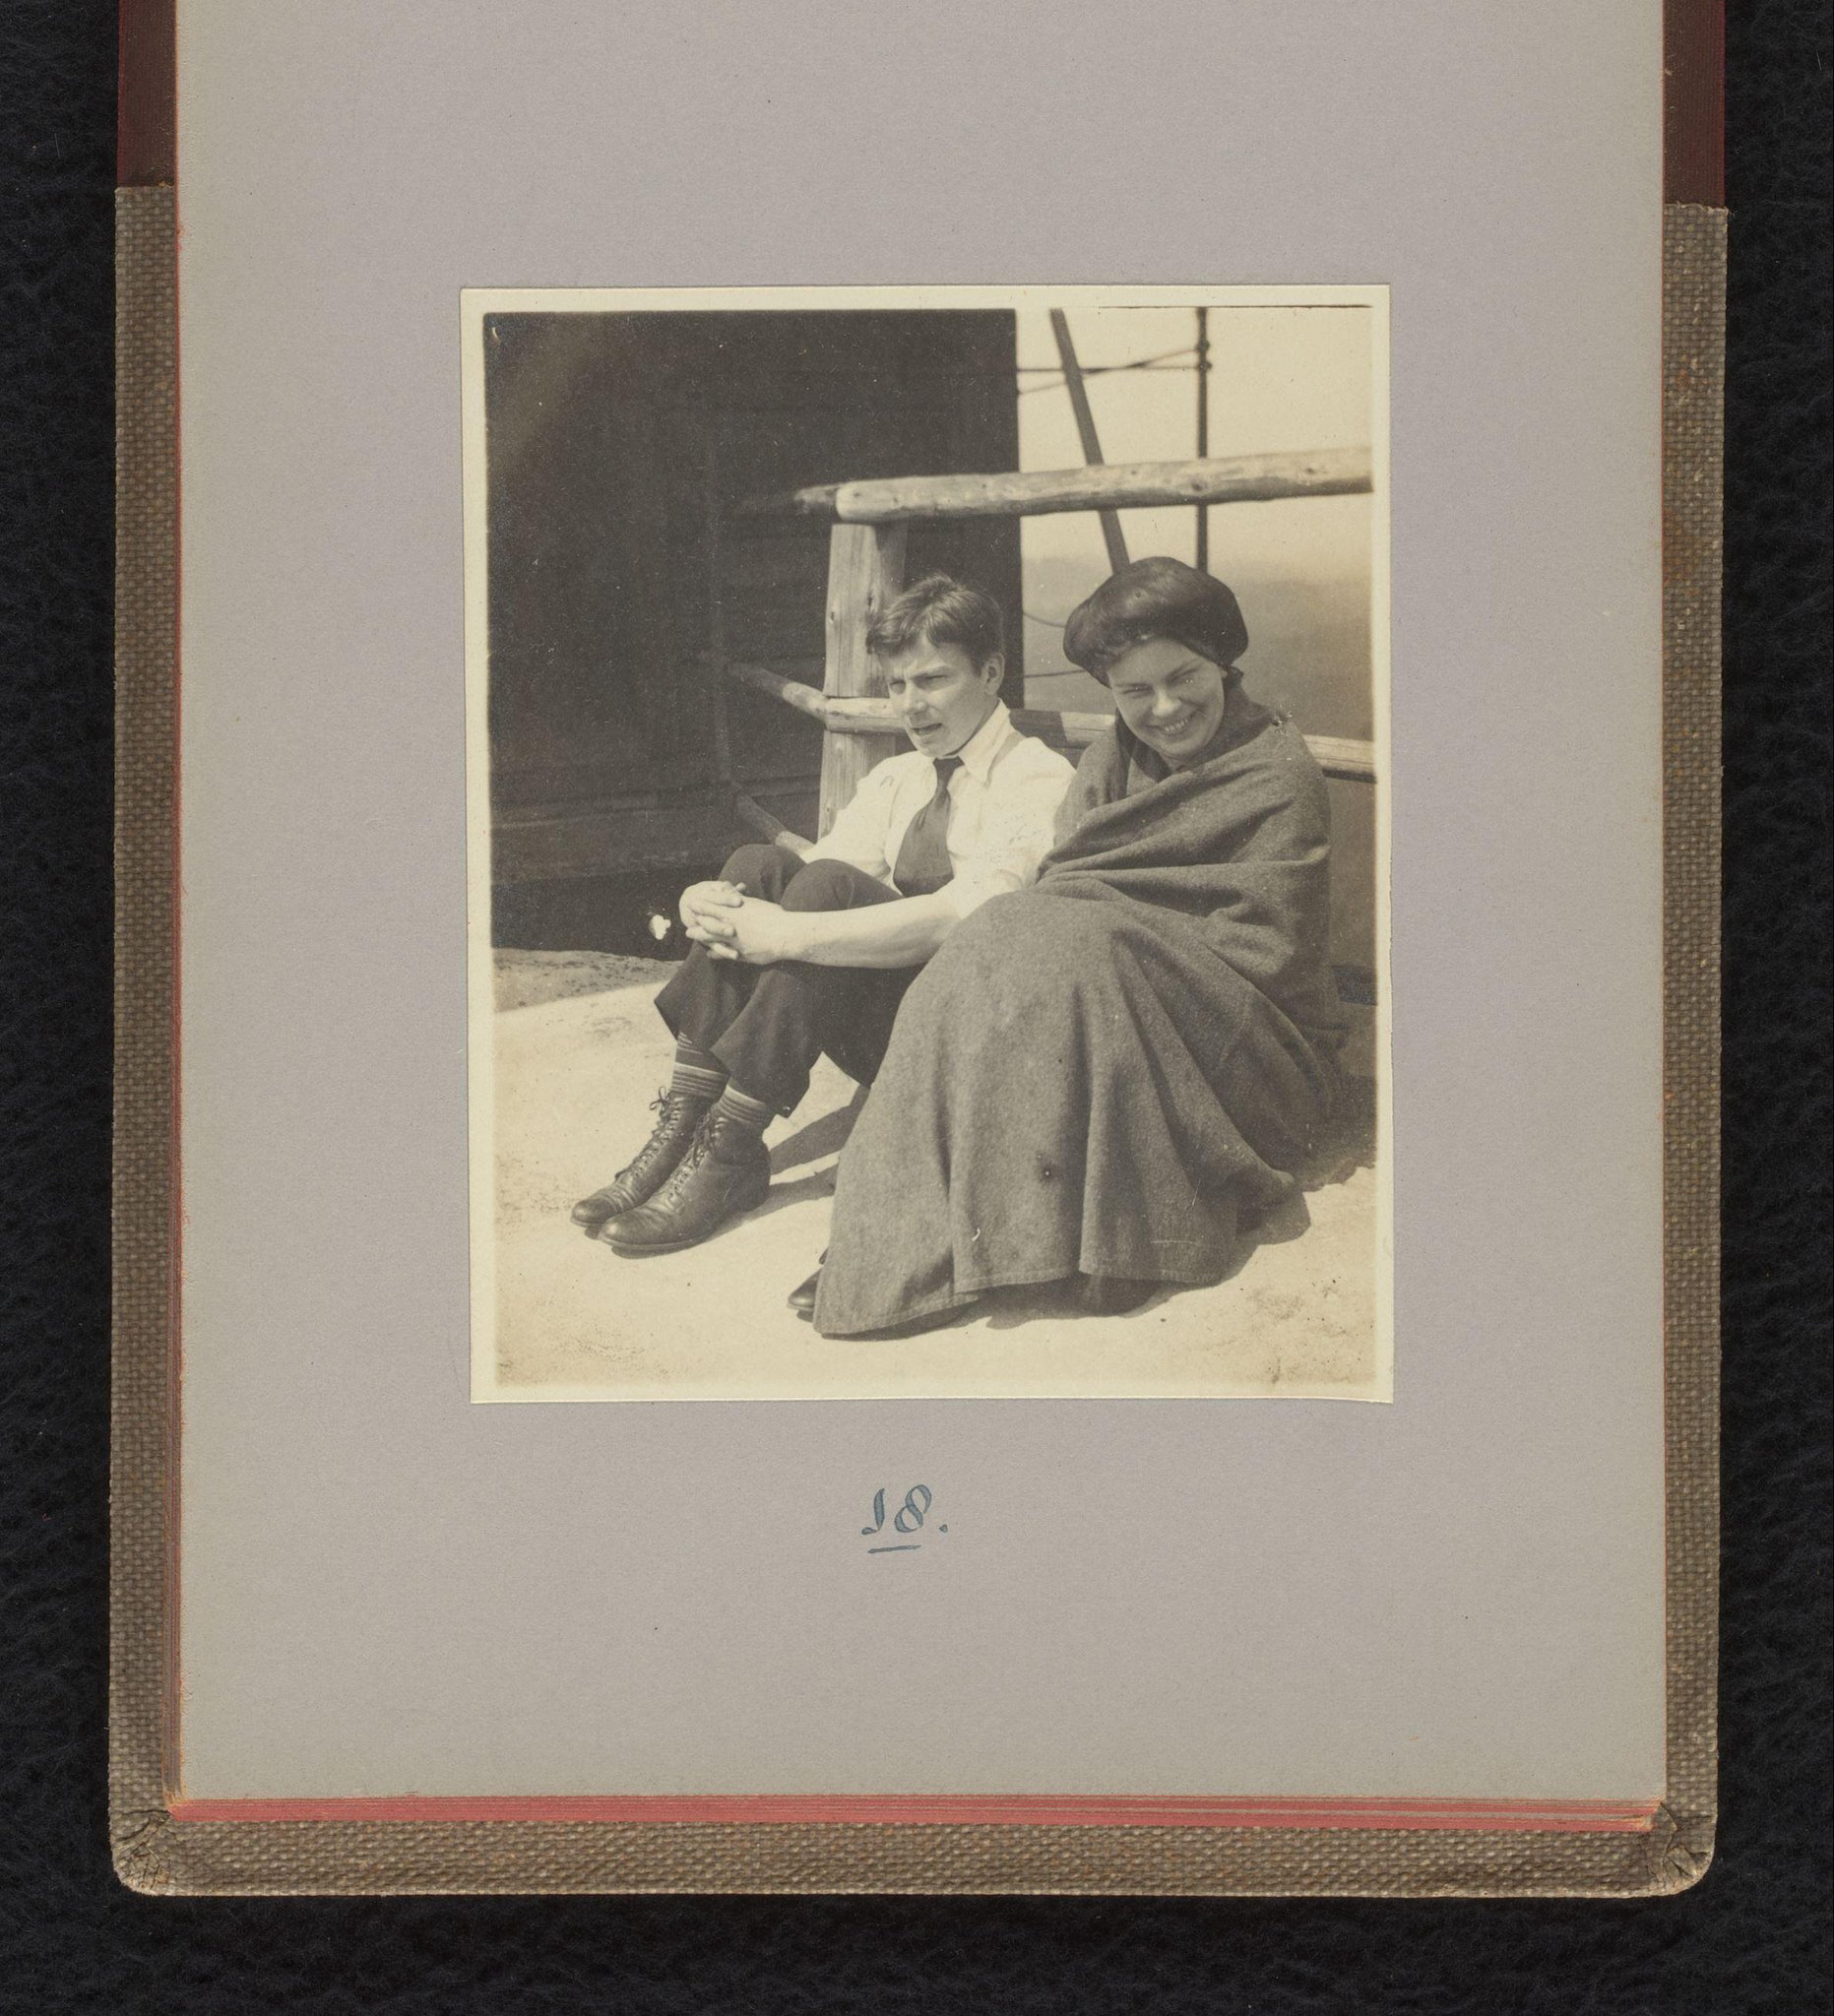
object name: album leaf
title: Marienfels - "was ist das leben wunderschön"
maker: hermann johannes kessler (boelie)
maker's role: voetballer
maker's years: 1896-1971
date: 1910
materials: paper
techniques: gelatin silver print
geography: marienfels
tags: johan herman kessler (jan), sitting figure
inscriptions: number: ‘18’